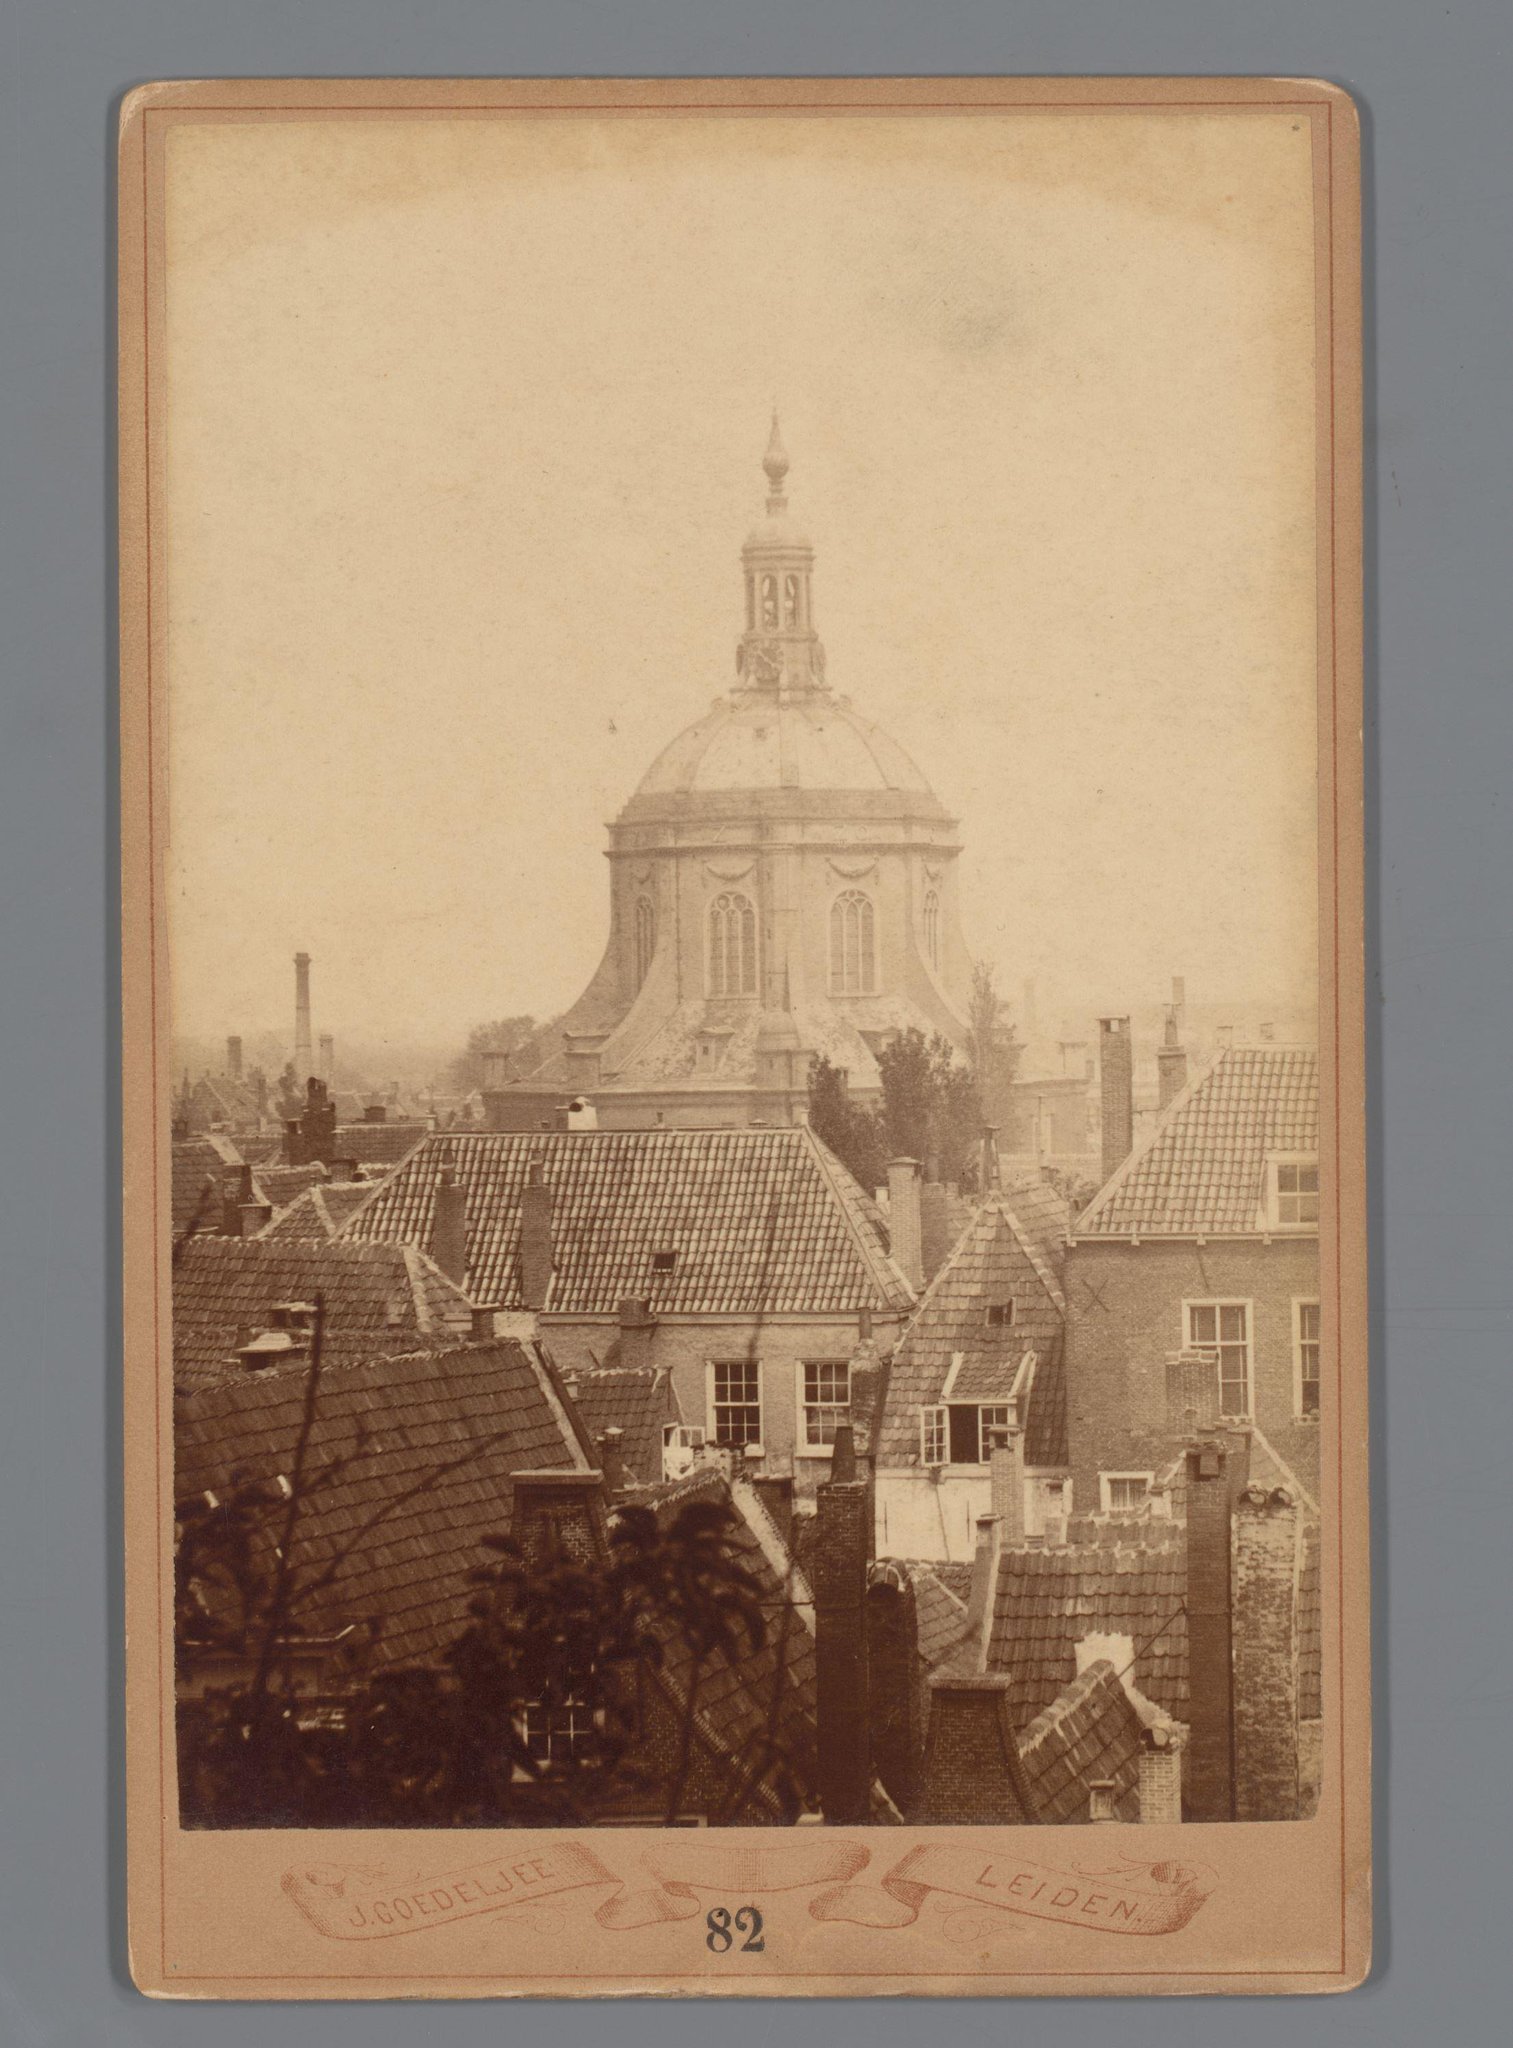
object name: photograph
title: Gezicht op de Marekerk te Leiden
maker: jan goedeljee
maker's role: fotograaf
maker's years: 1824-1905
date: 1879-1900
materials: cardboard, photographic support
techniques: albumen print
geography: leiden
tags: church (exterior), leiden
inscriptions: annotation: ‘De Marekerk’, inscription: ‘J. Goedeljee (...) Leiden/ Hoogewoerd 160/ naby de Plantage’, inscription: ‘J. Goedeljee/ Leiden/ 82’